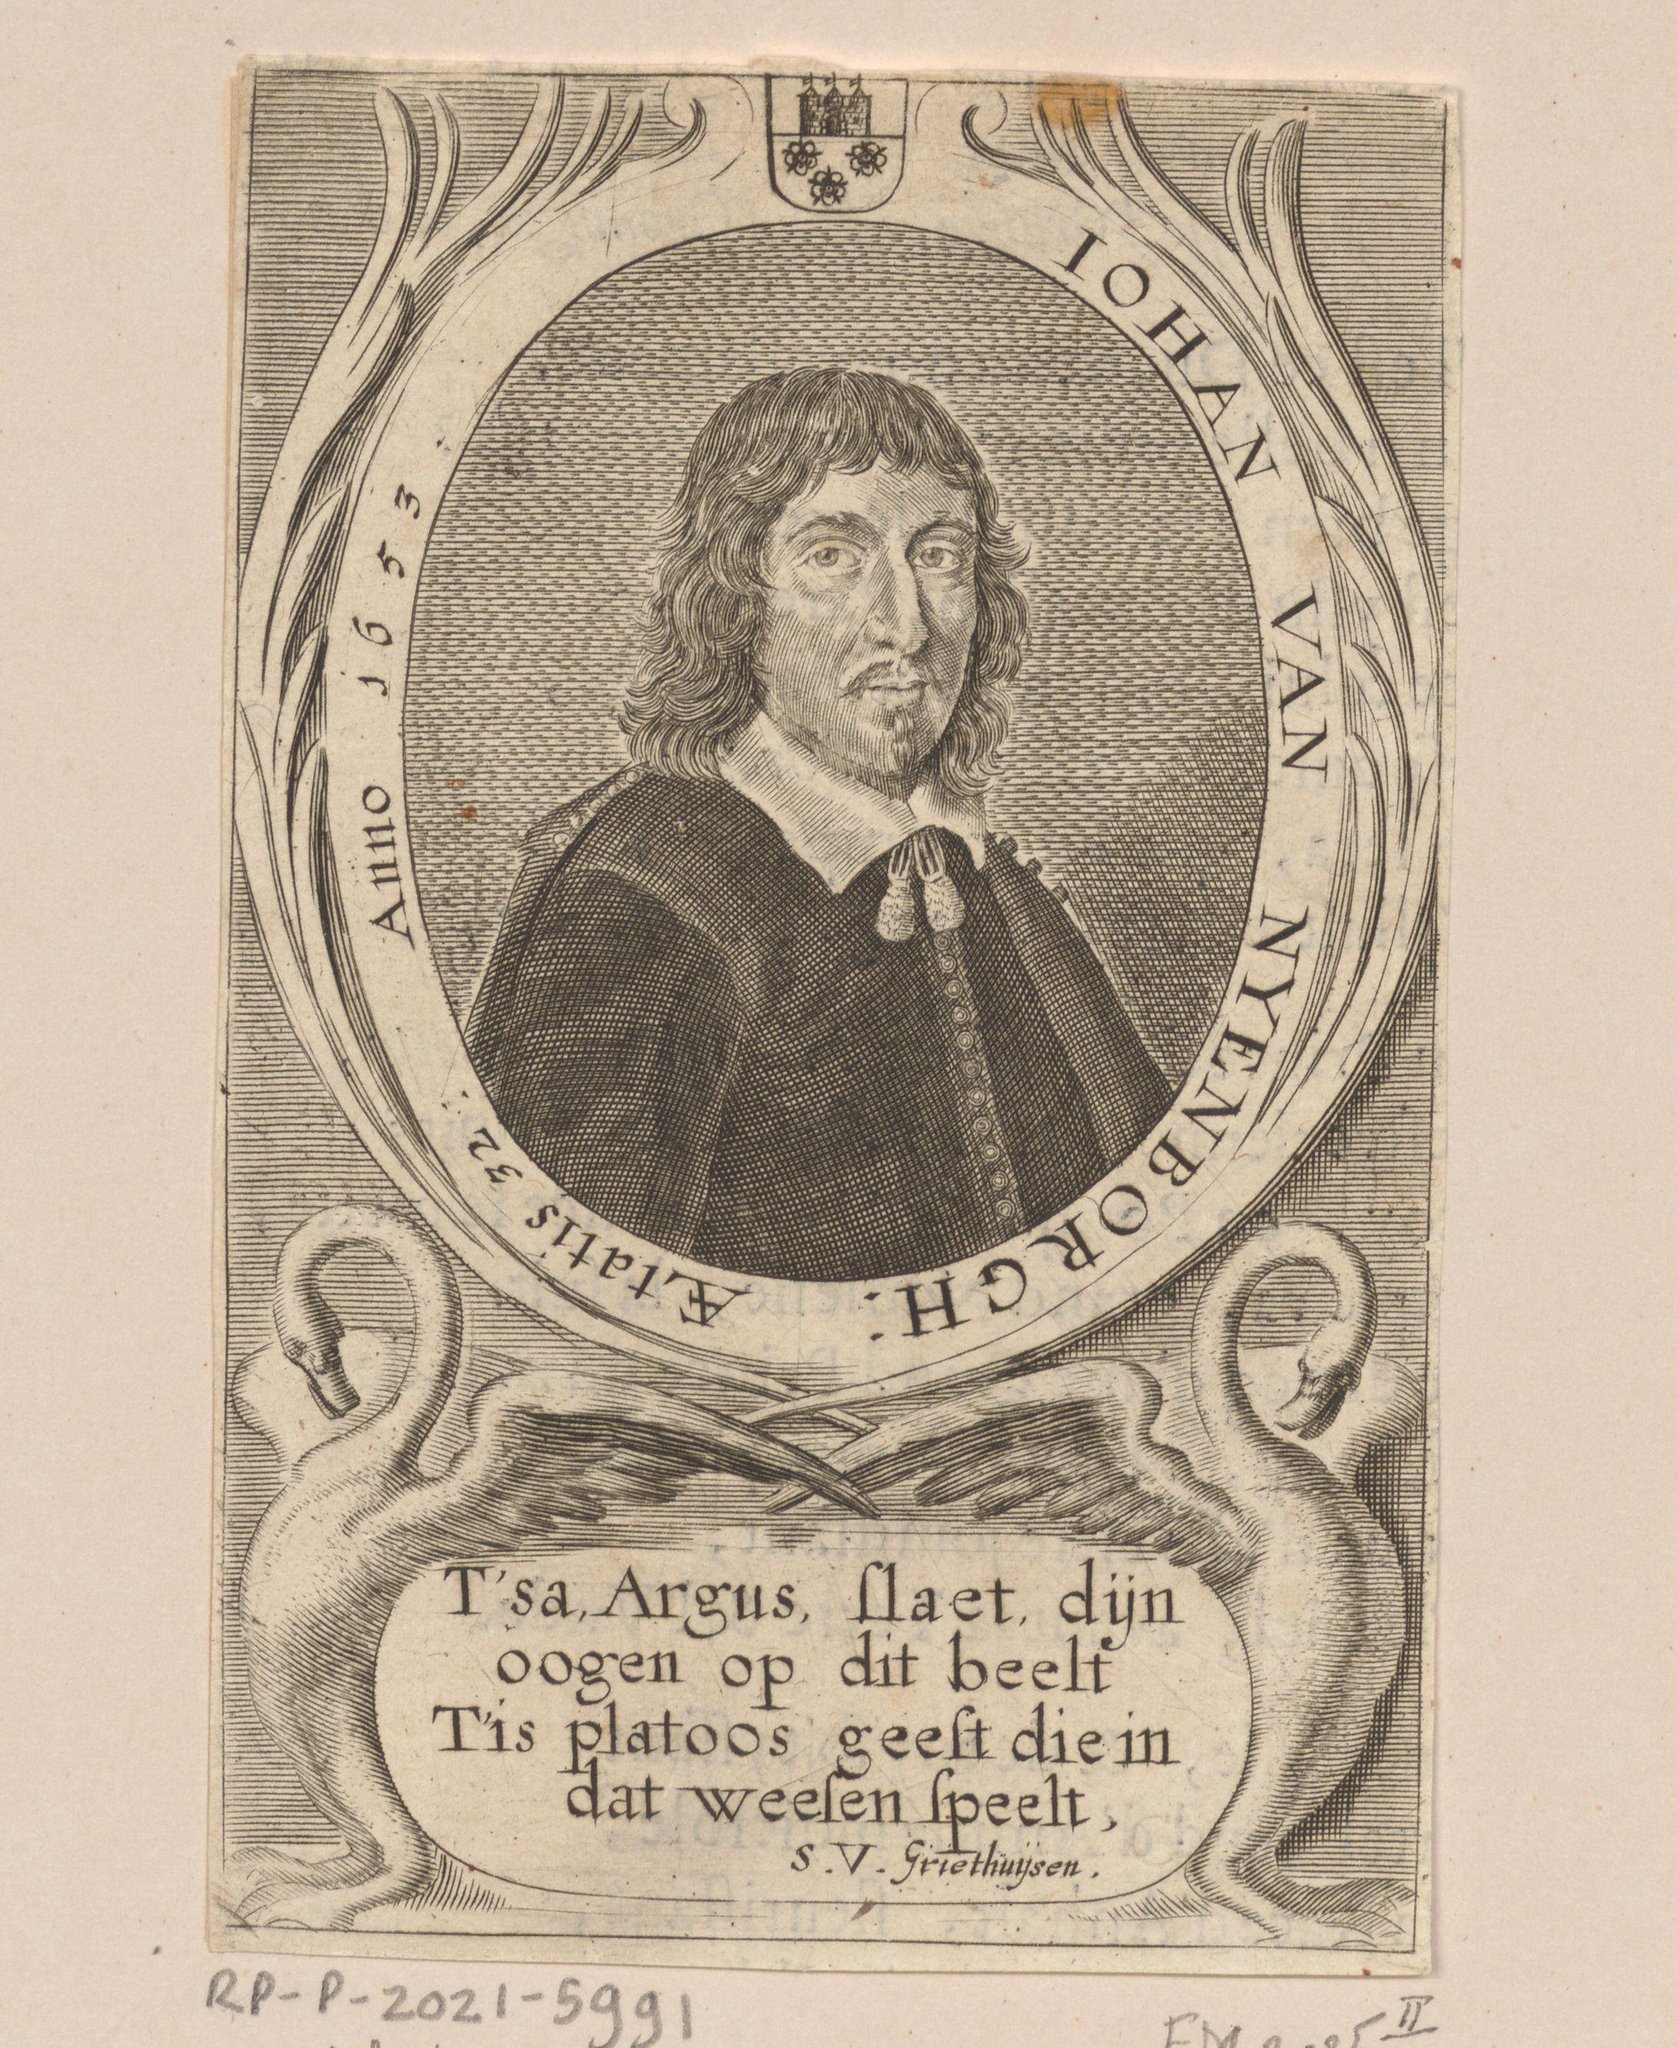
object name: print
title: Portret van Johan van Nijenborgh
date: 1659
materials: paper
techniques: engraving, letterpress printing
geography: groningen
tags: water-birds: swan, historical persons, writer, poet, author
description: Prent uit: Nijenborgh, Johan van. I.V. Nyenborchs hofstede met desselfs andere bedenckingen (...). Groningen: s.n., 1659.